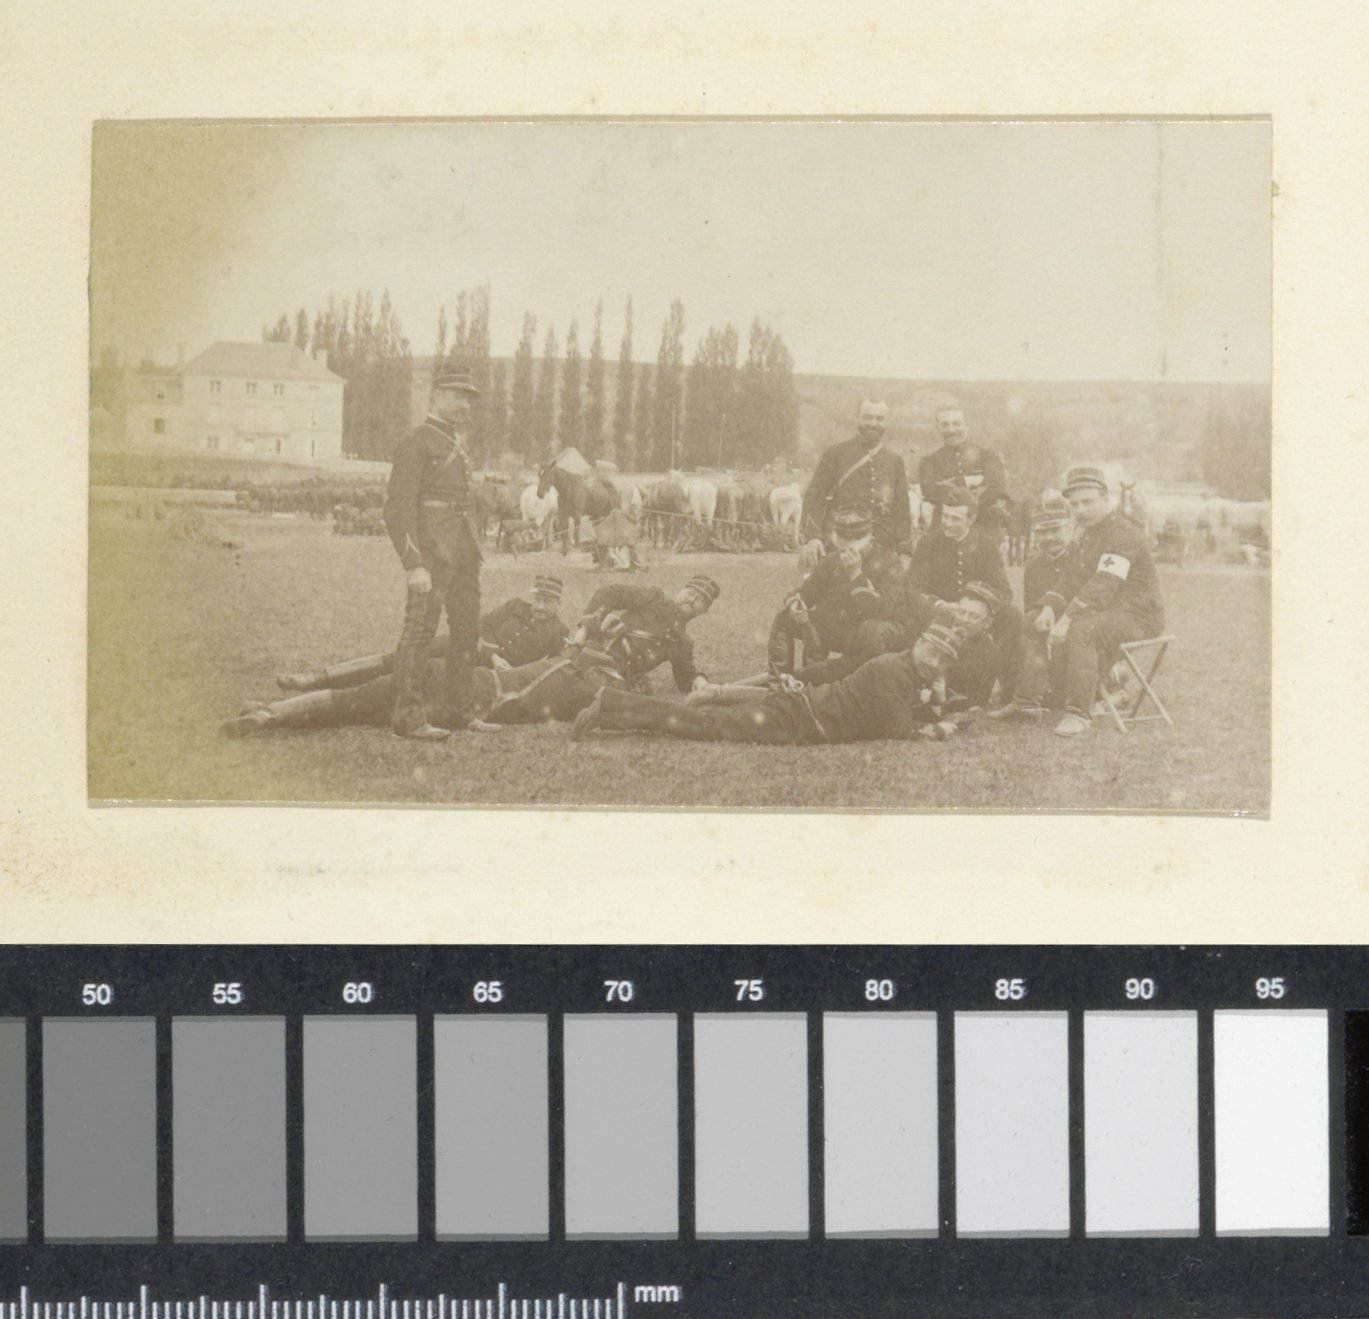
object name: photograph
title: Groep militairen poserend op een grasveld in Frankrijk, op de achtergrond paarden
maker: Anonymous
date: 1900-1910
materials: paper, photographic support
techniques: albumen print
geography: france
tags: land forces (+ cavalry, horsemen), france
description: Onderdeel van Fotoalbum van een Franse amateurfotograaf met opnames van een familie, distilleerderij Delizy & Doistau Fils, het leger en bezienswaardigheden in Frankrijk.